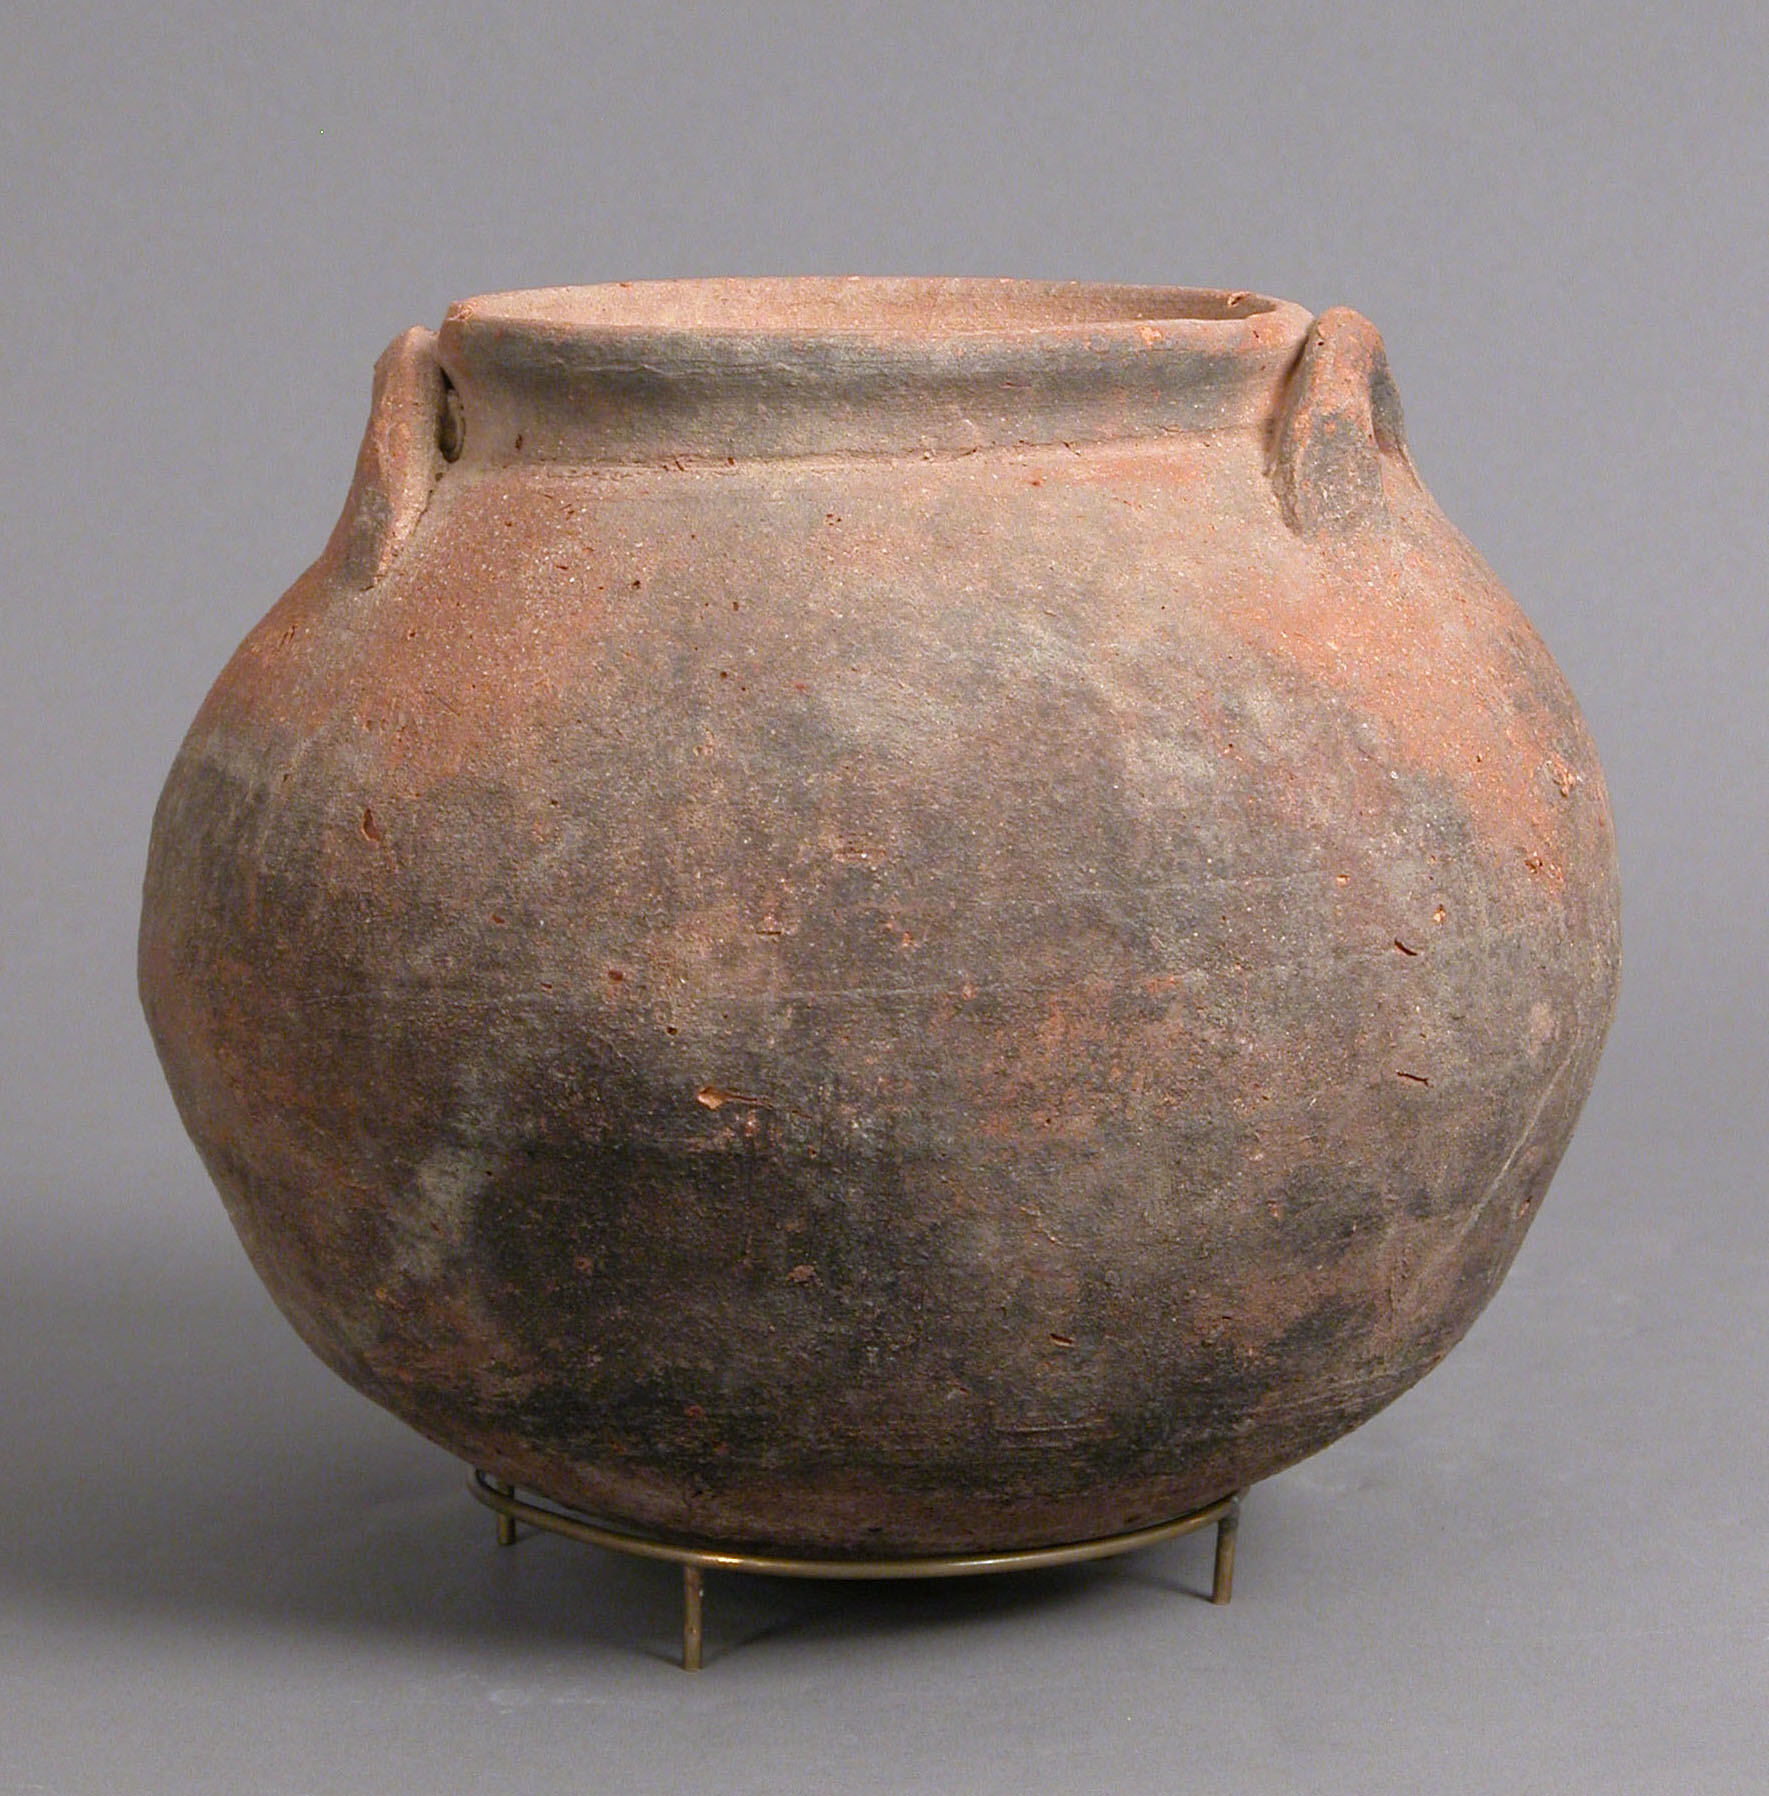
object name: pot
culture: coptic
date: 401-900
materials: earthenware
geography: egypt